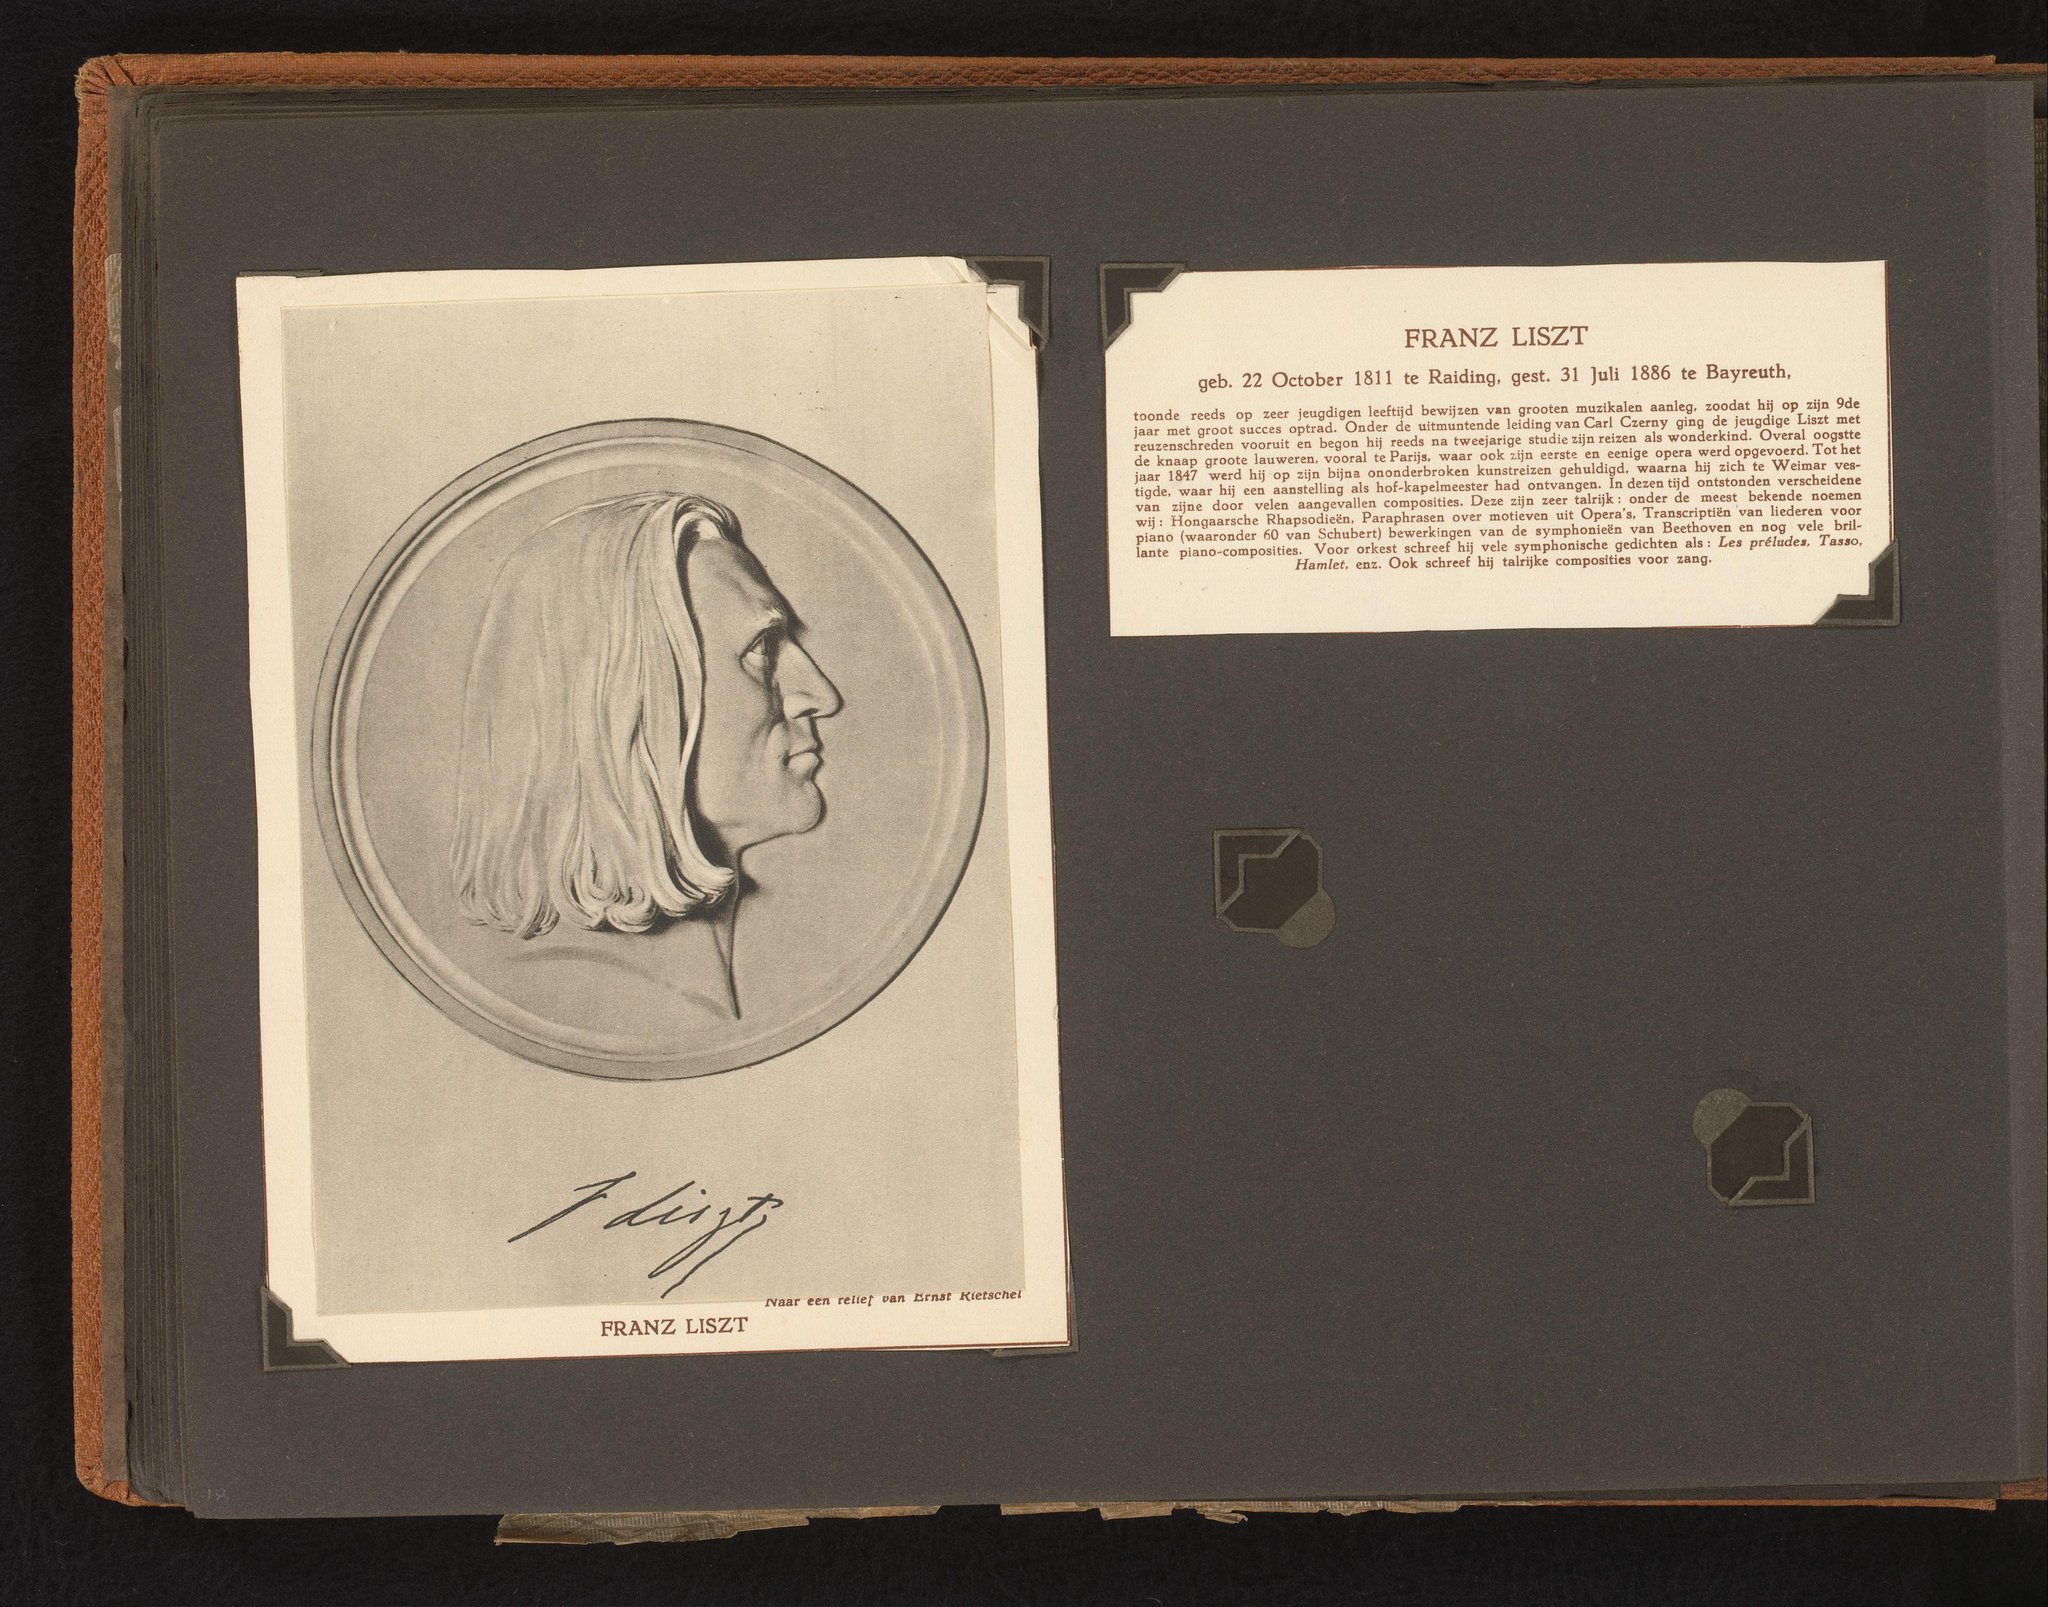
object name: photomechanical print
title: Franz Liszt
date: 1933-1936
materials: paper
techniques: rotogravure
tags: portrait of composer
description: Albumblad met een portret van en een tekst over de componist Franz Liszt. Onderdeel van het Esperanto album uit ca. 1933-1936.